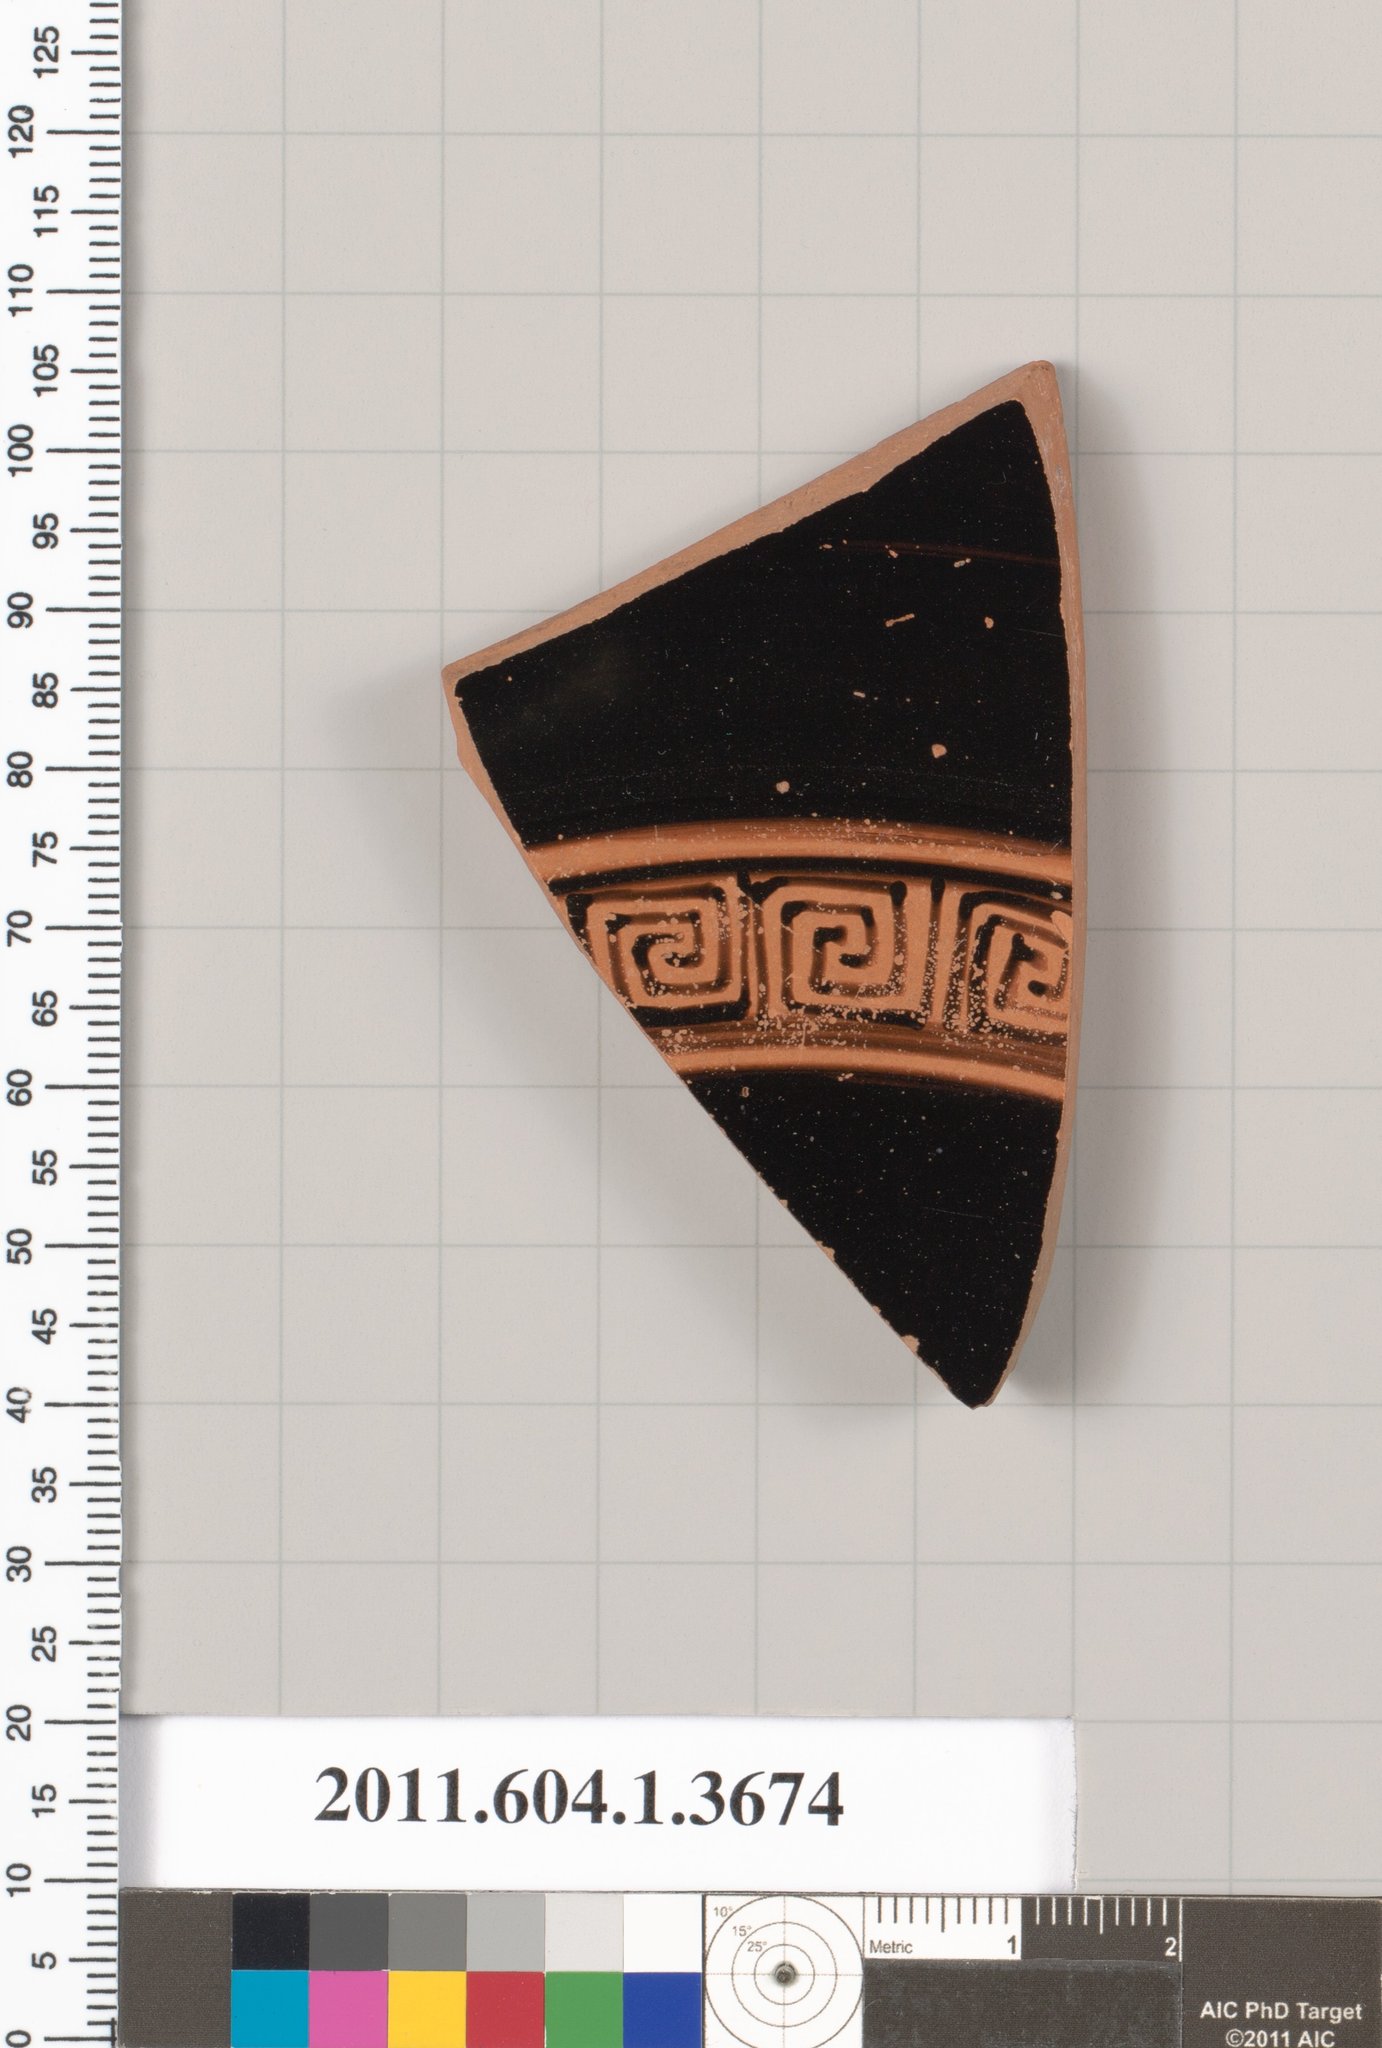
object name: kylix fragment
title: Terracotta fragment of a kylix (drinking cup)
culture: greek, attic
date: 475-451 BCE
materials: terracotta